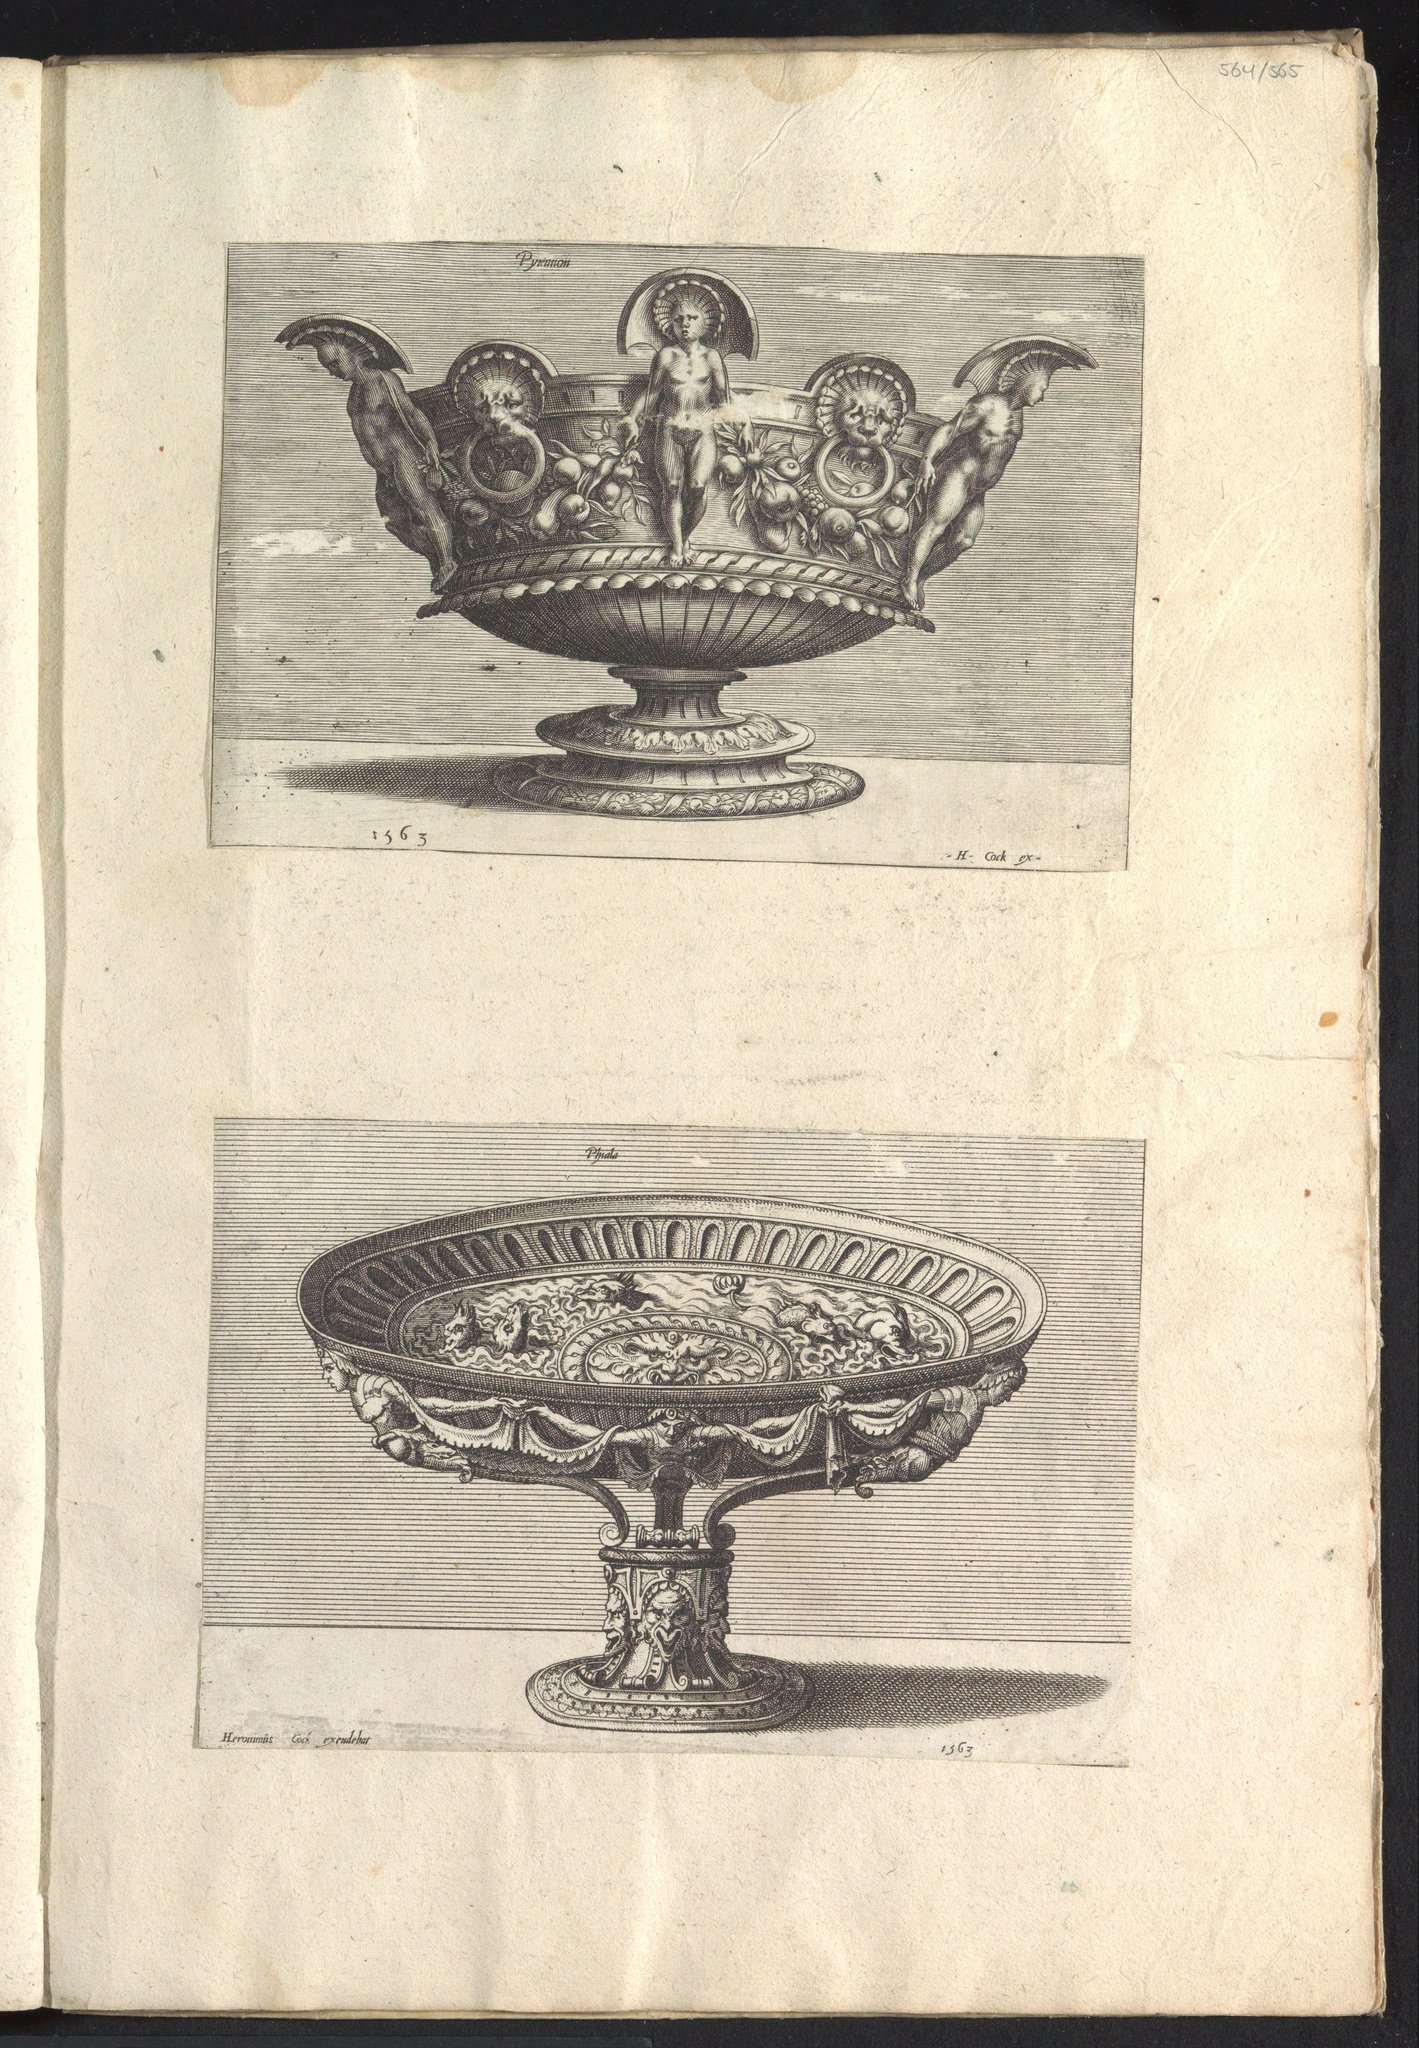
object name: album leaf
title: Albumblad met twee prenten van schalen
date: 1563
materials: paper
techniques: engraving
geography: antwerp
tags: dish, plate, saucer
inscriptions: date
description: Albumblad met twee uitgeknipte prenten van ornamentele schalen.